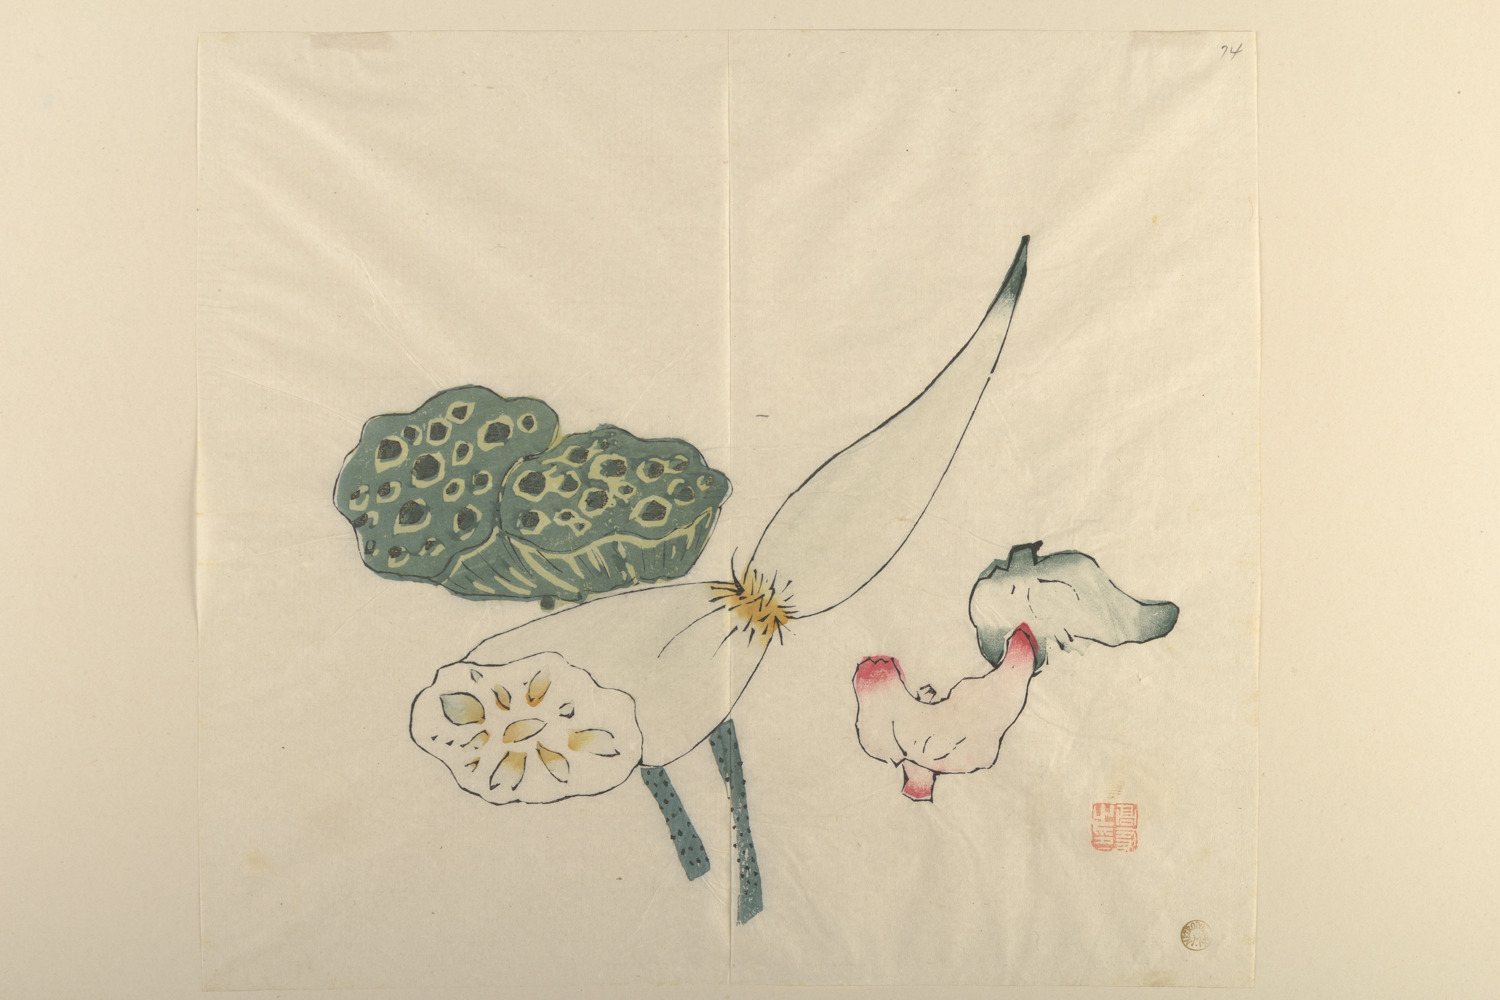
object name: print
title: Page from Shi Zhu Zhai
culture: chinese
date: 1736-1795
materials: ink, paper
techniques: polychrome, woodblock print